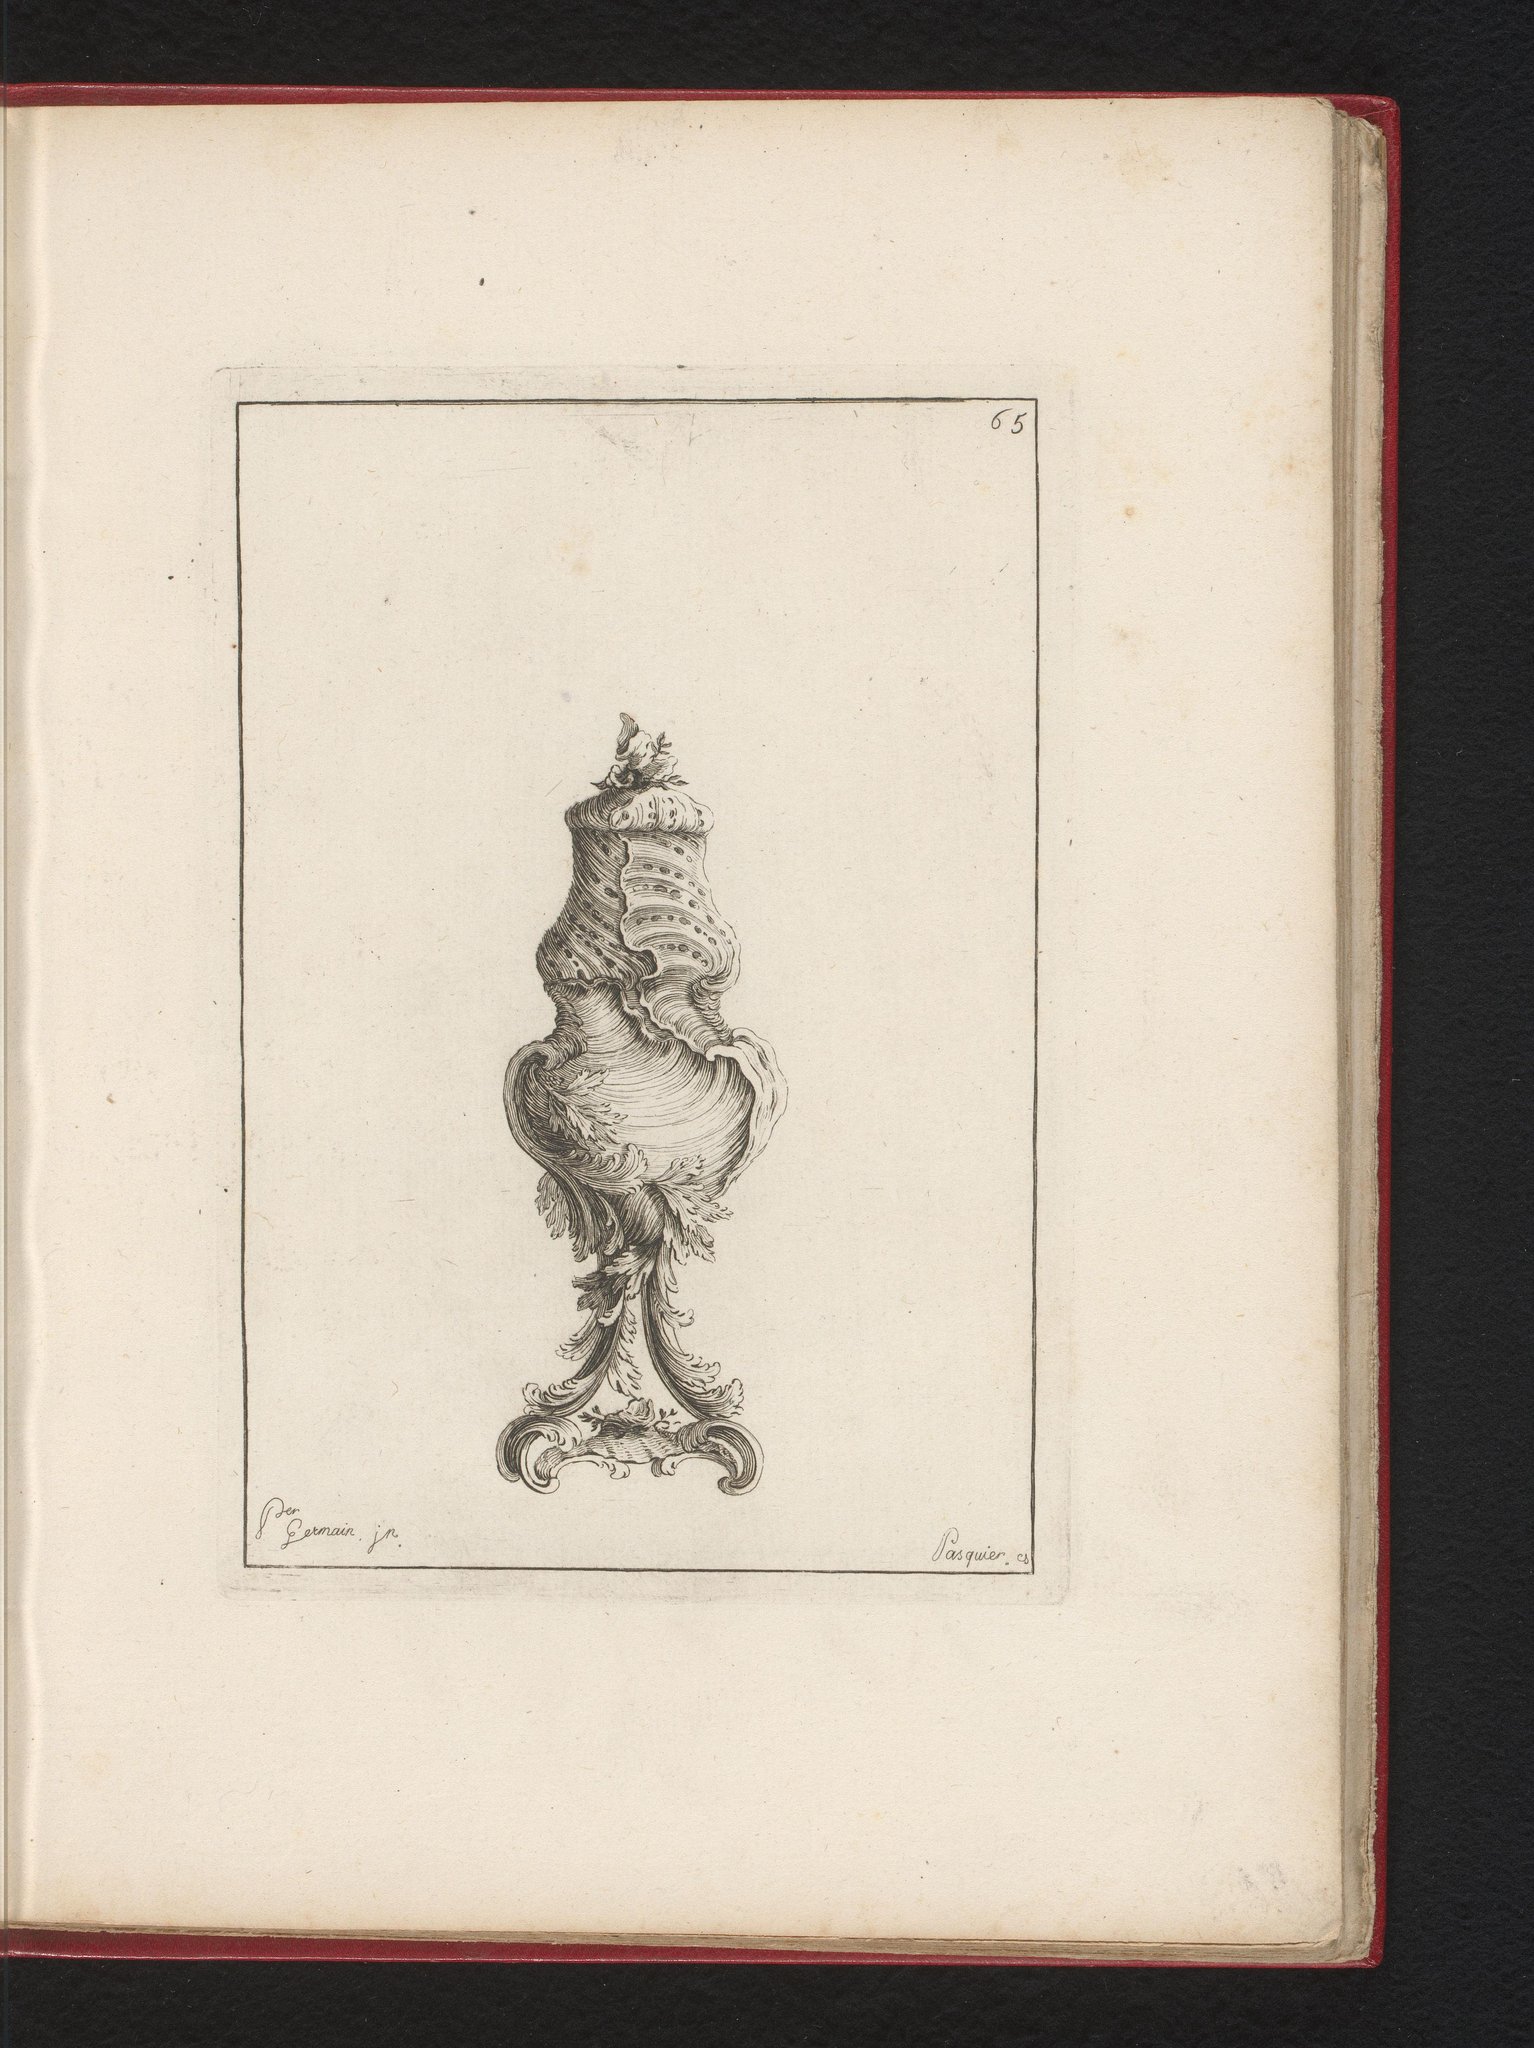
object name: album leaf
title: Ontwerp voor een suikerpot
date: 1748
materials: paper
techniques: etching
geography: paris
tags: sugar-basin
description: Een aantal van de objecten in deze reeks heeft een eigen ondertitel, die verwijst naar genummerde 'cahiers' (afleveringen) waarin de prenten werden uitgegeven. Het is onduidelijk welke objecten recies bij welke aflevering horen. Daarom is die ondertitel enkel verwerkt bij de prent waarop die voorkomt.